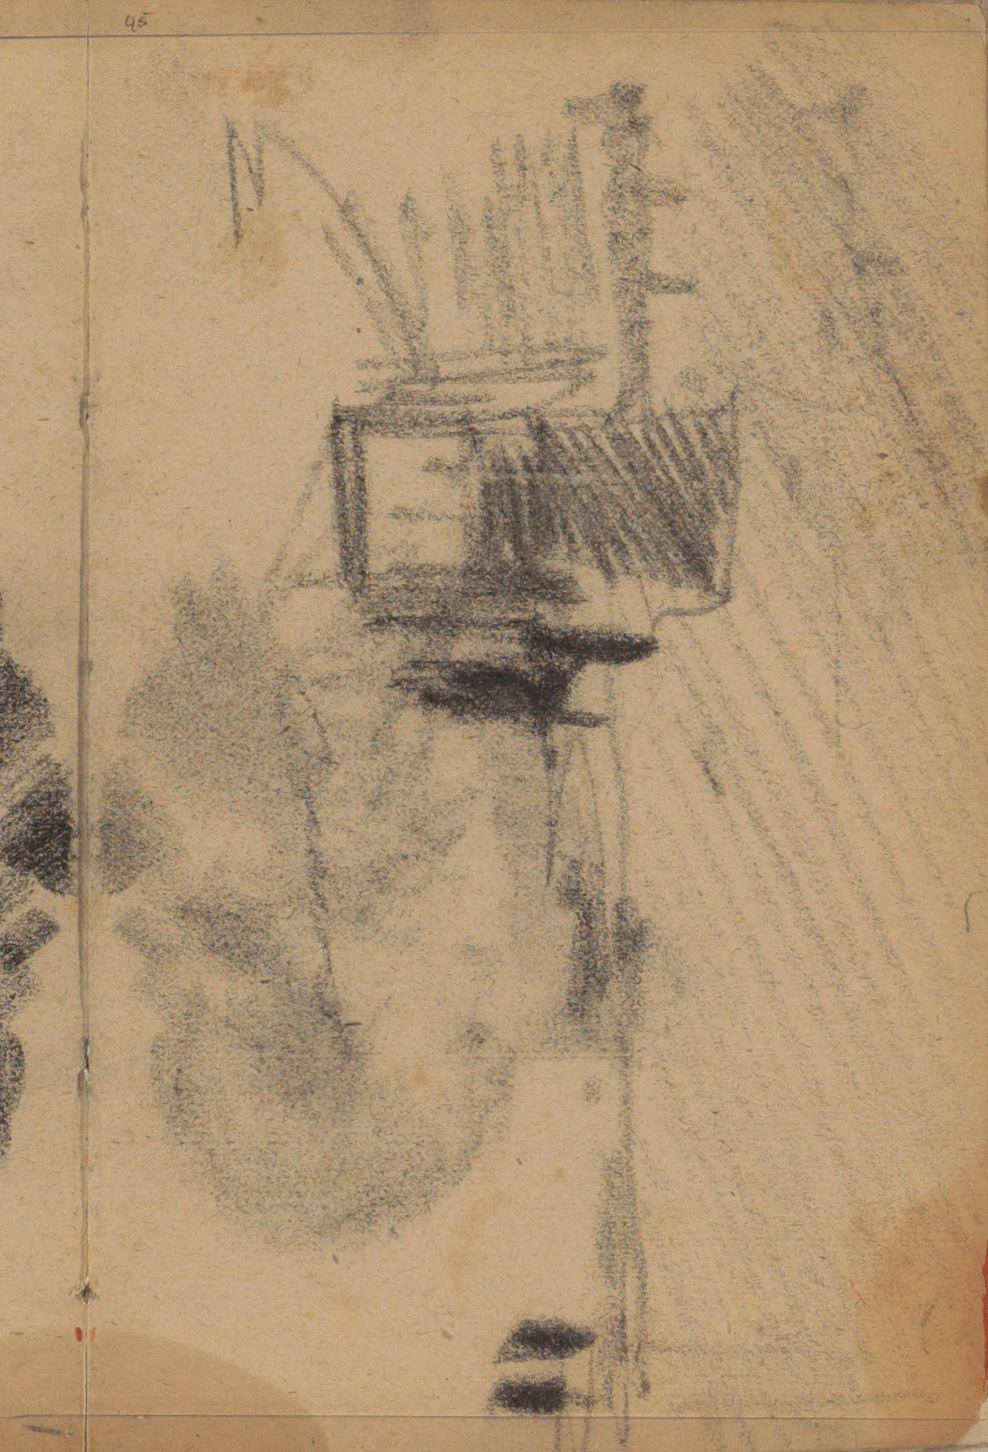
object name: sketchbook leaf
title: Landschap met paard-en-wagen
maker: george hendrik breitner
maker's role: draughtsman, painter, print maker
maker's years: 1857-1923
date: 1881-1883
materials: chalk, paper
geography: south holland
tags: four-wheeled, animal-drawn vehicle, e.g.: cab, carriage, coach, horse, beach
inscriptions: annotation: ‘zand’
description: Landschap, mogelijk het strand, met paard-en-wagen. Rechts twee figuren. Pagina 45 uit een schetsboek met 70 bladen.